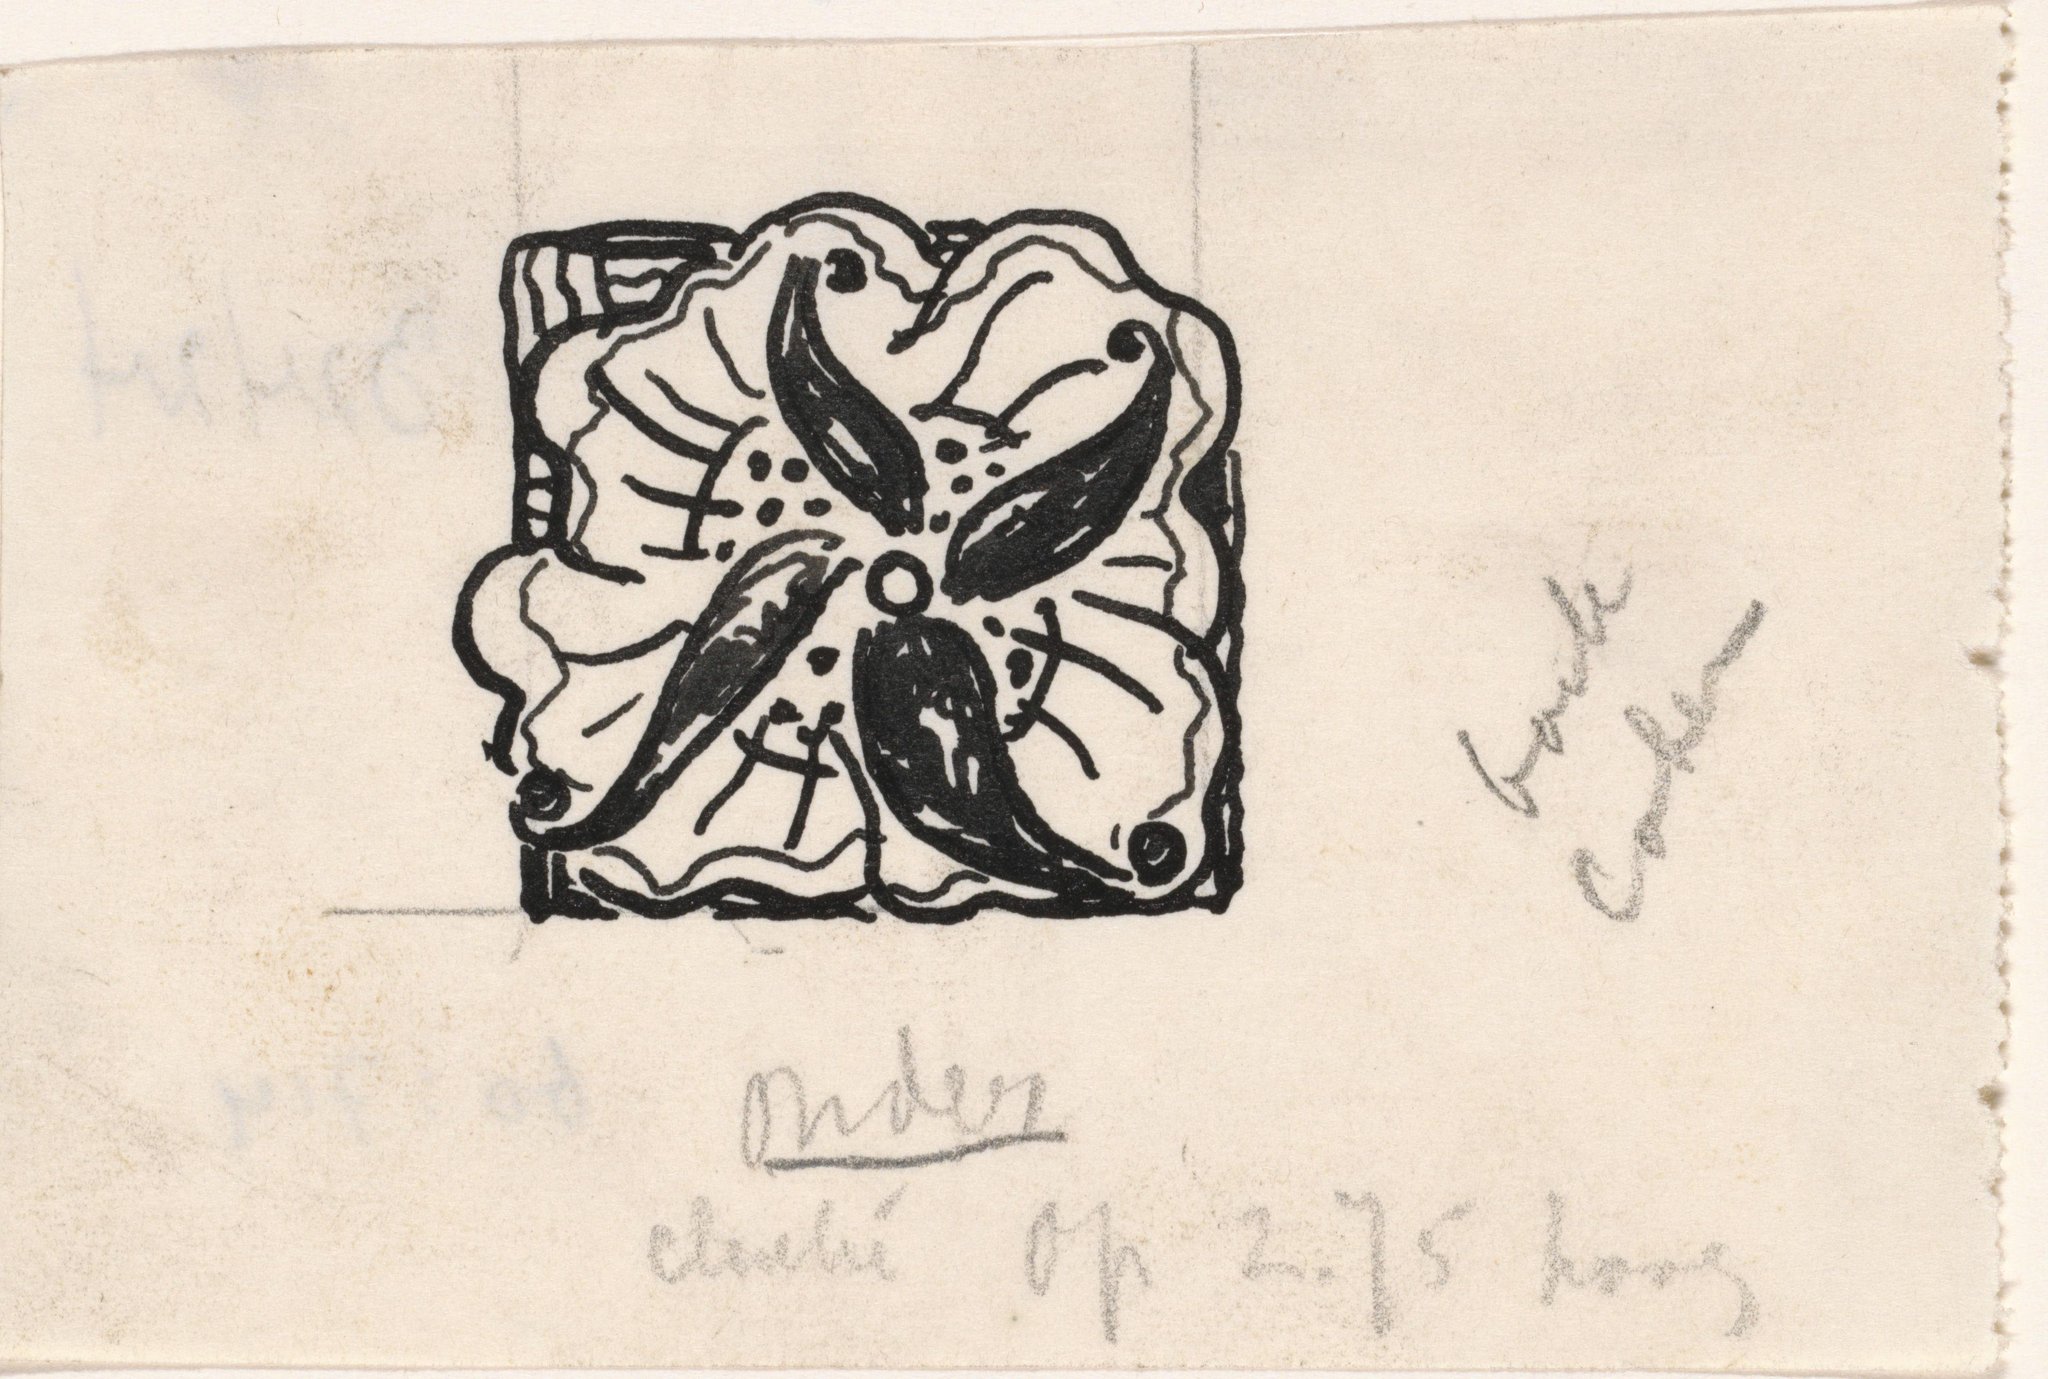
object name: drawing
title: Bloem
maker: leo gestel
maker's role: draughtsman, print maker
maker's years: 1881-1941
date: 1934-1936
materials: ink, paper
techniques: brush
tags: lizards, (cohen, van anarchist tot monarchist) specific works of literature (with author, title)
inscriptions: clichéaanwijzing, recto, handgeschreven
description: Ontwerp voor een boekillustratie voor: Cohen, Alexander. Van anarchist tot monarchist. Amsterdam: De Steenuil, 1936.